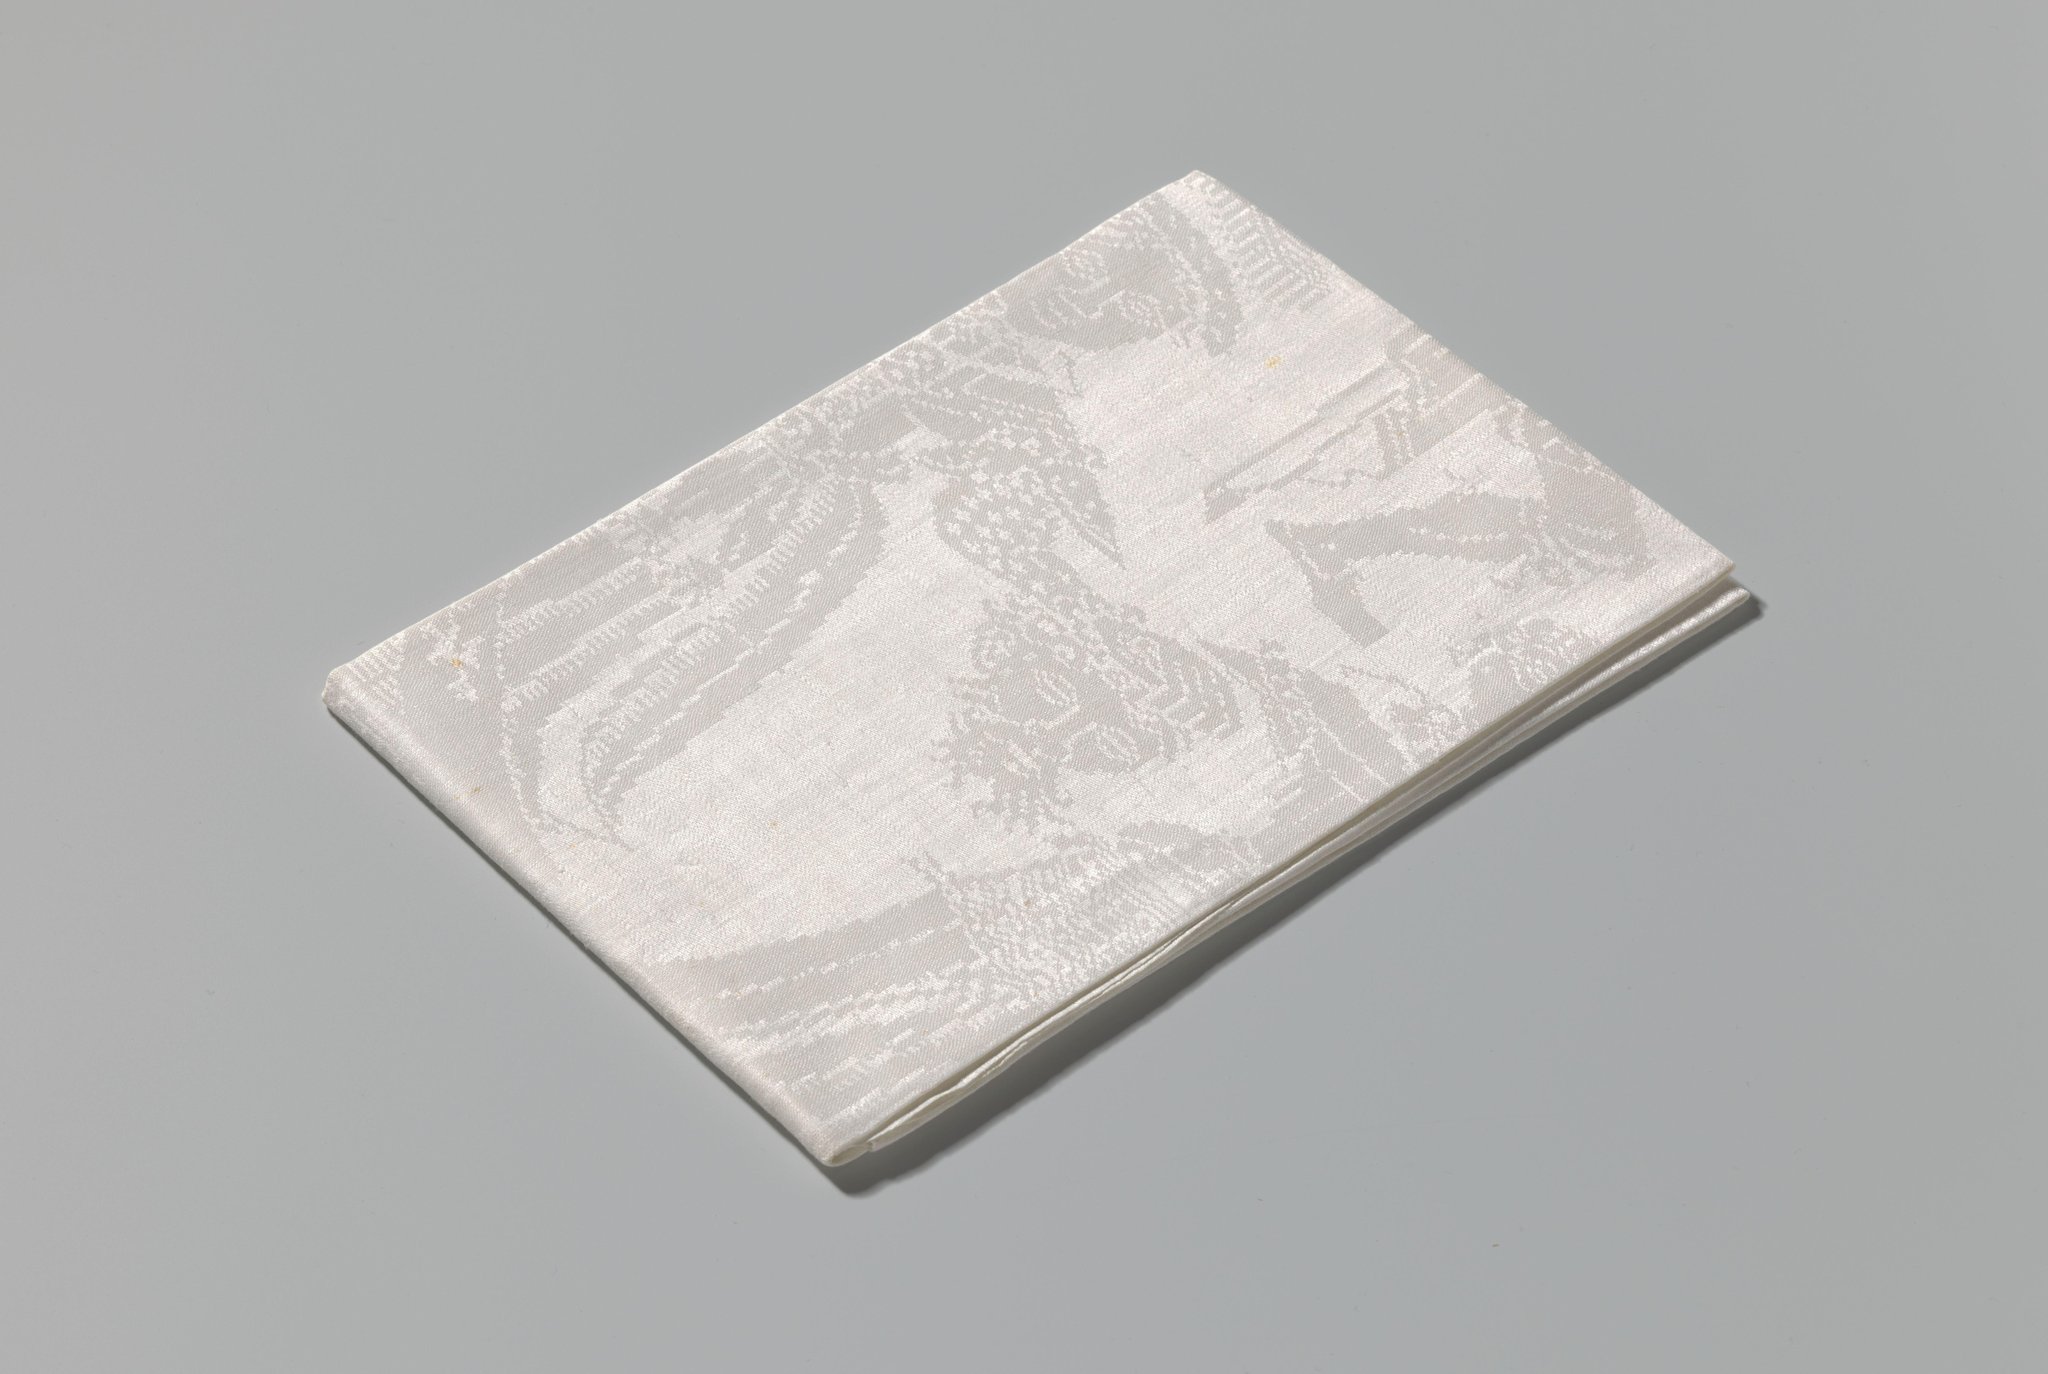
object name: napkin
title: Servet van wit linnendamast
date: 1600-1625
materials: linen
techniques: damask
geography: netherlands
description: Wit linnen damasten servet met de geschiedenis van Judith en Holofernes. Merk SVW en 14.